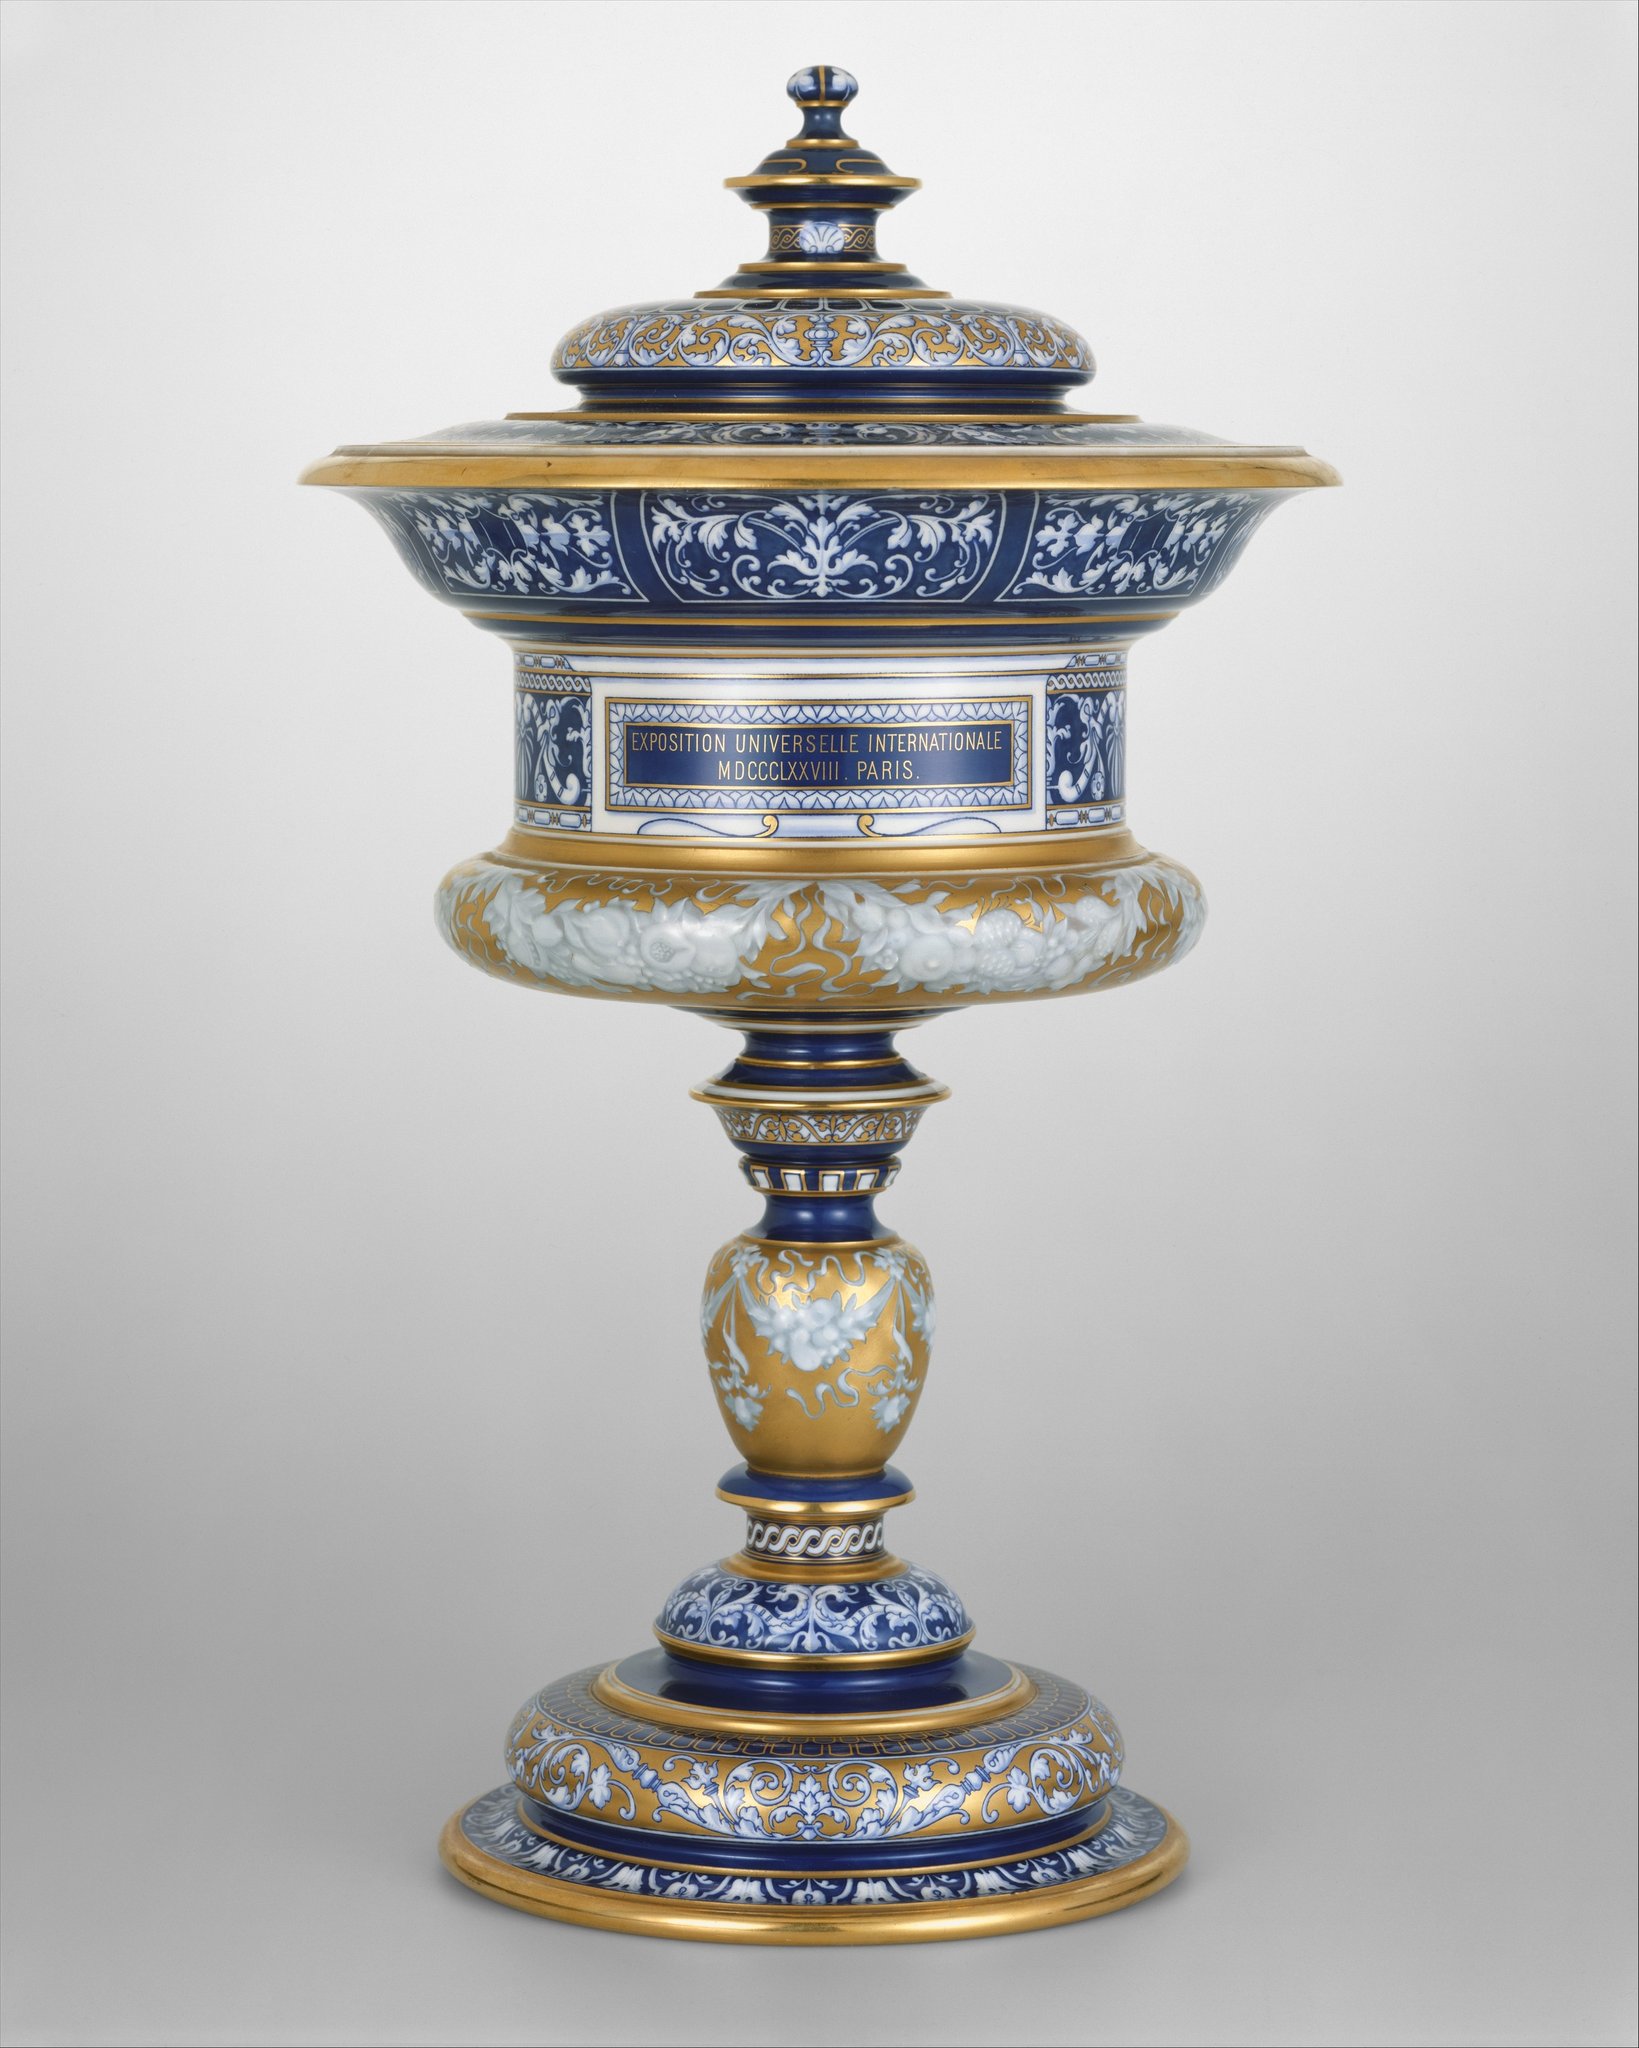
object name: standing cup with cover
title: Standing cup with cover (vase couty or coupe couty)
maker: sèvres manufactory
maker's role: manufactory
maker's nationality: french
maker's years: 1740-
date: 1879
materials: hard paste porcelain